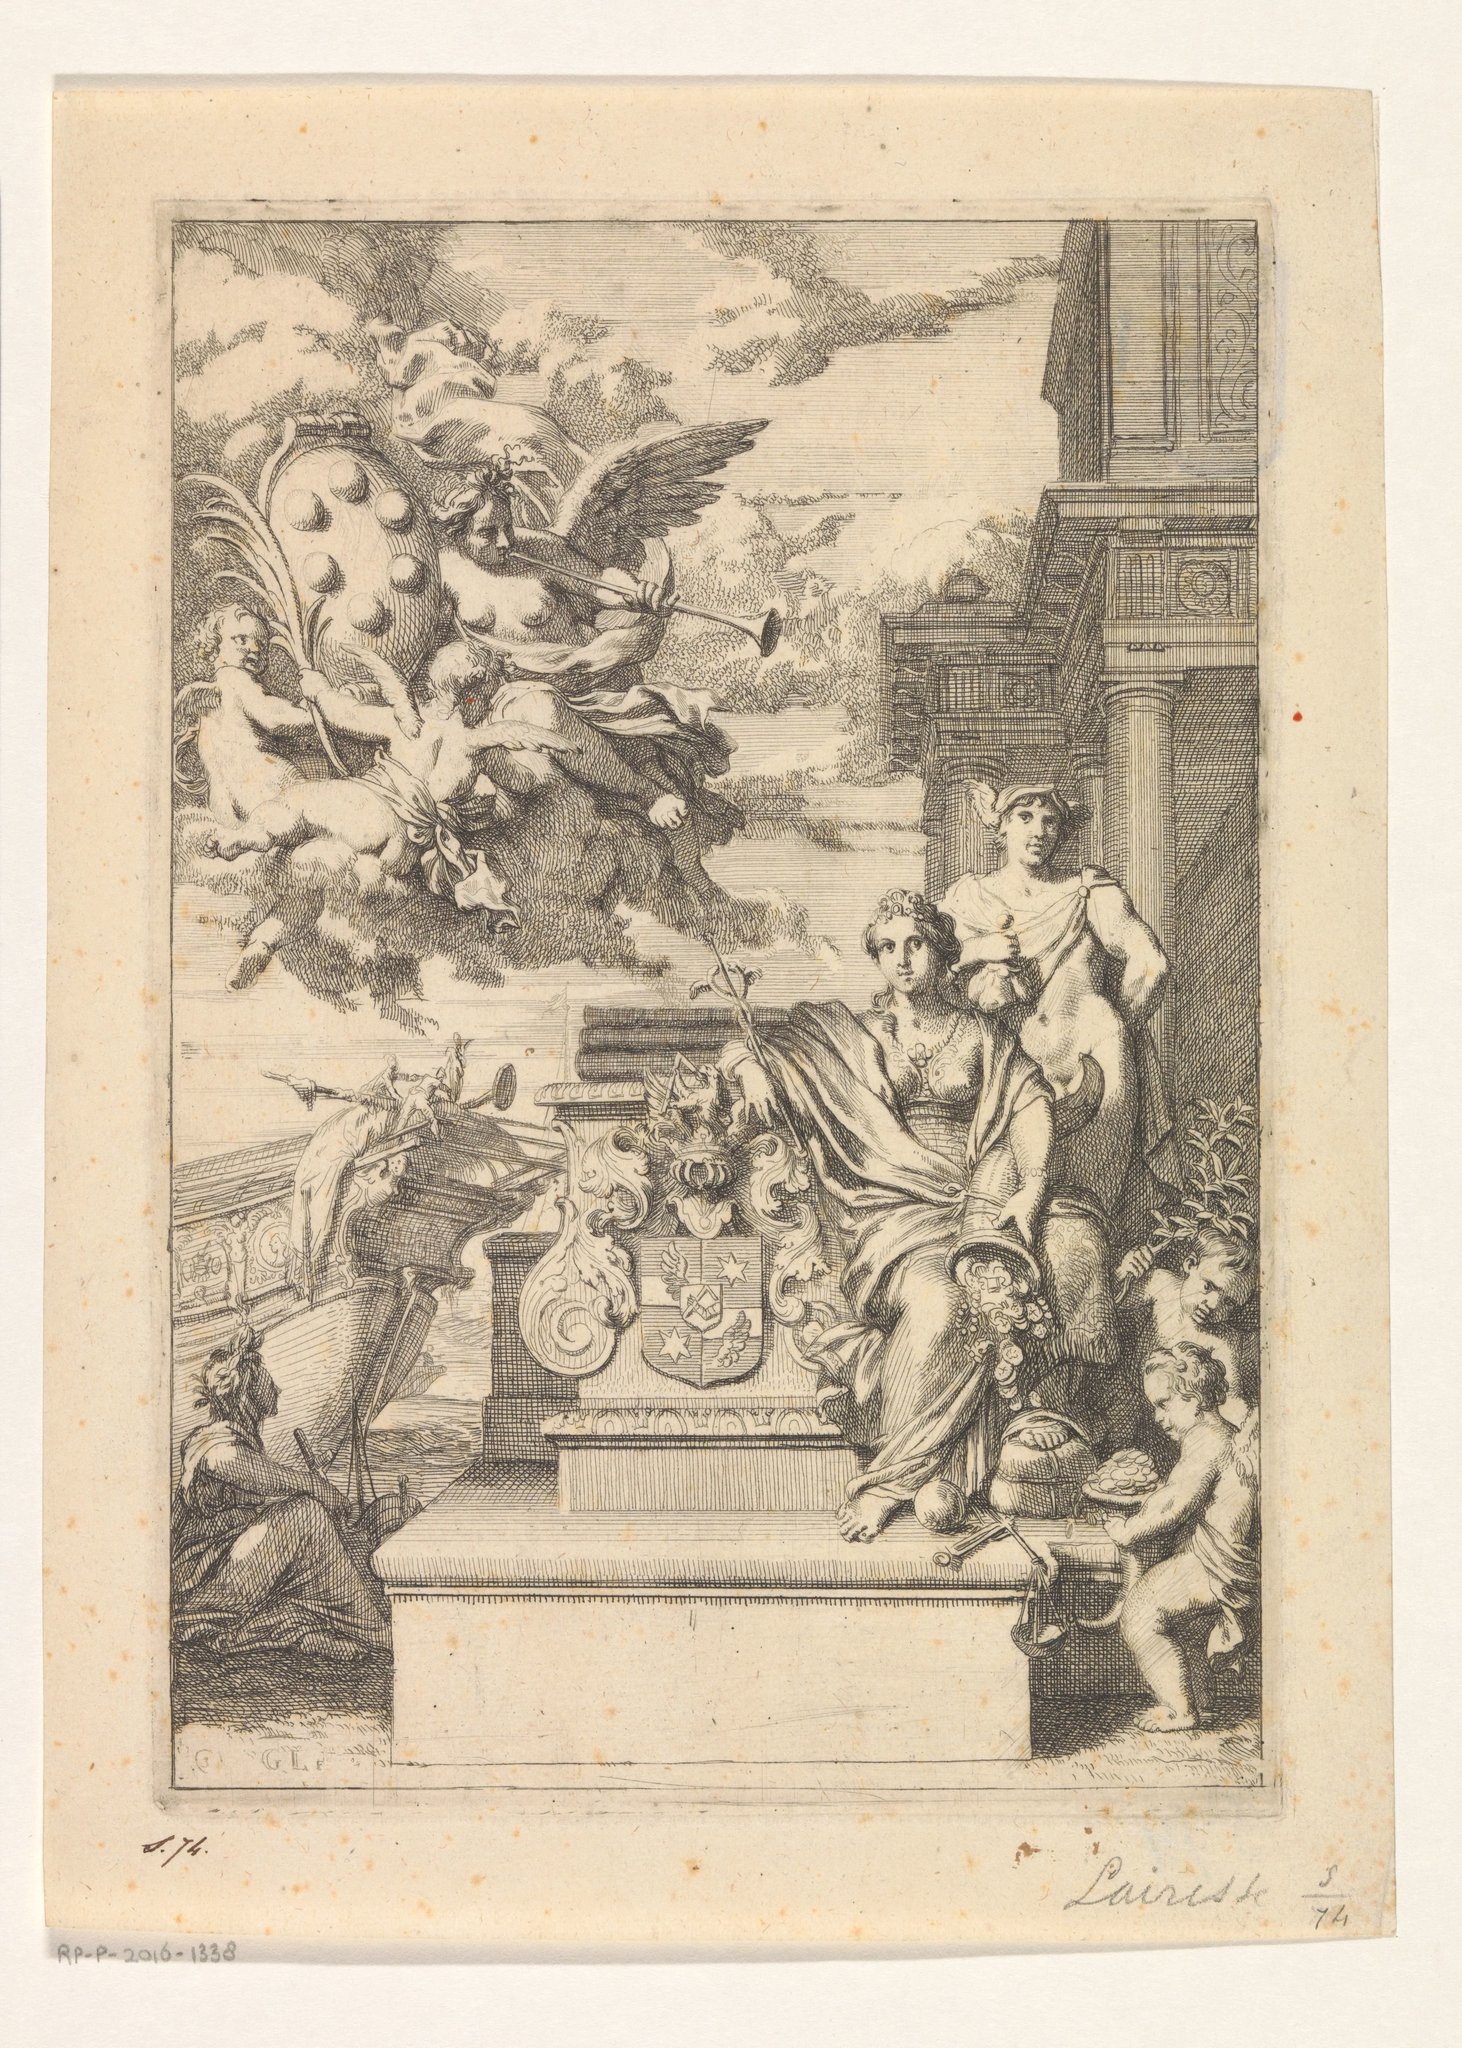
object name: titelblad, titelpagina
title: Titelpagina met een allegorie op de handel en het familiewapen van De Medici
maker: gerard de lairesse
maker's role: draughtsman, painter, print maker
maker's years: 1641-1711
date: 1670-1675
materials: paper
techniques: etching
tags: allegory of trade; 'commertio della vita humana' (ripa), armorial bearing, heraldry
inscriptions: number: ‘S.74’, collector's mark: Lugt 11, collector's mark: ‘Hinloopen’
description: Bij een rijk versierd wapenschild zit een vrouwelijke personficiatie met de hoorn des overvloeds (welvaart) en de caduceus (vrede) in haar handen. Aan haar voeten ligt een weegschaal (rechtvaardigheid). Naast haar staan twee putti met een met geld gevulde hoorn en een olijftak (respectievelijk symbolen van welvaart en vrede). Achter de vrouwfiguur staat Mercurius, god van de handel, met een stokkenbeurs in zijn handen. Links ligt een schip aangemeerd. In de lucht prijkt het familiewapen van De Medici dat door de bazuin blazende Faam en twee putti wordt gedragen.